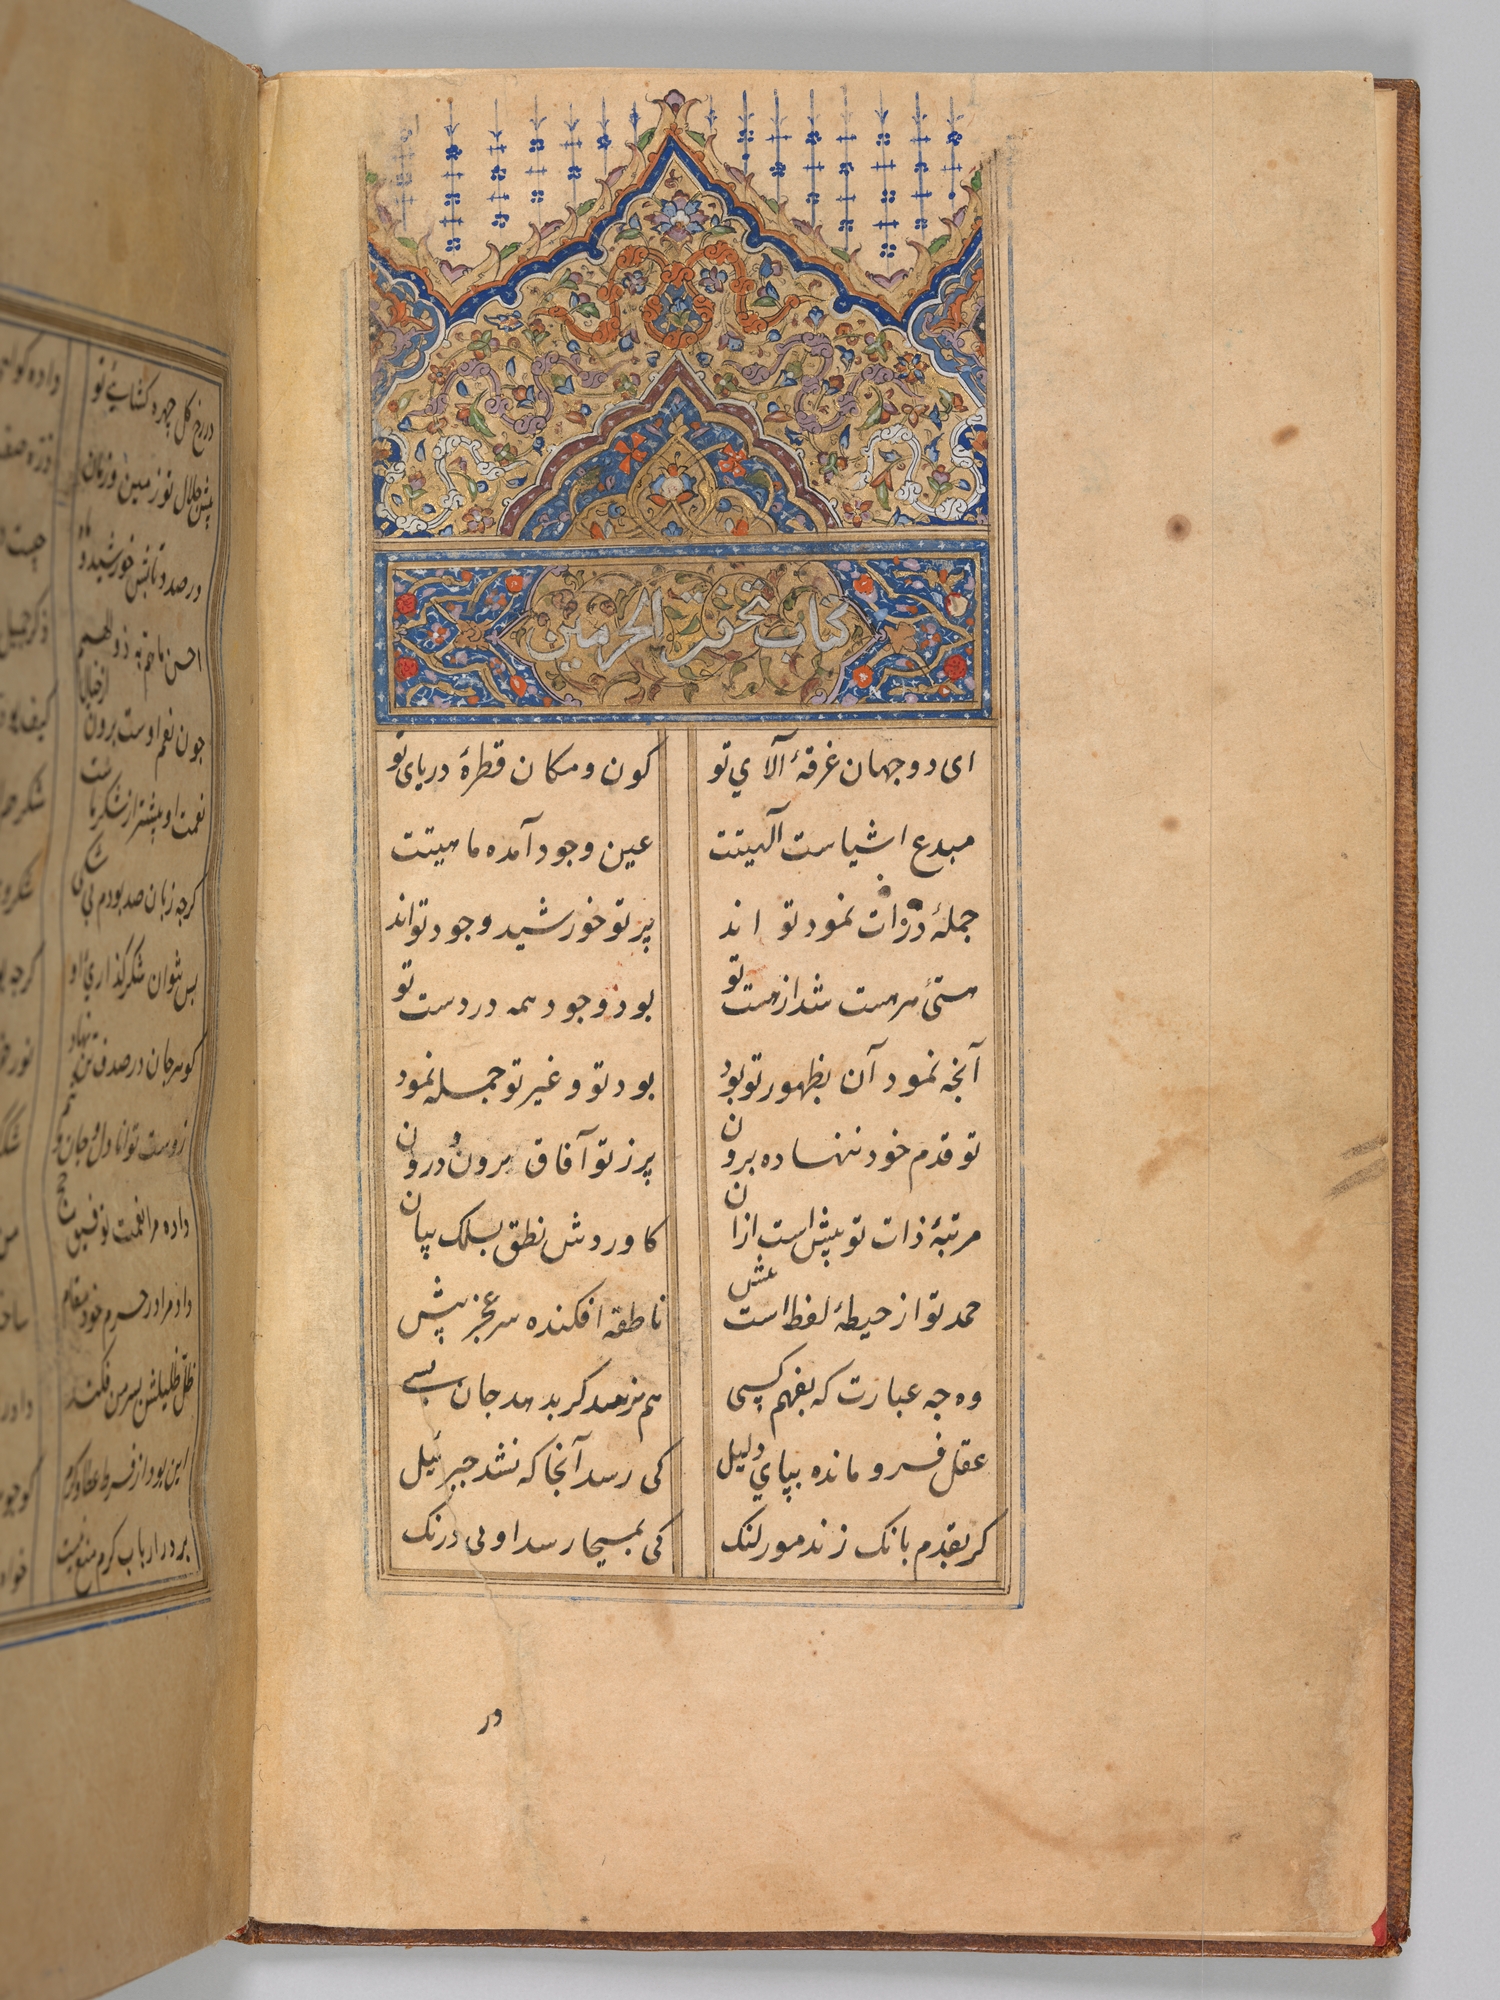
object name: illustrated manuscript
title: Futuh al-Haramain (Description of the Holy Cities)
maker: muhi al-din lari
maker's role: author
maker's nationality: iranian or indian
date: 1534-1566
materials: gold, ink, leather, paper, watercolor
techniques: bookbinding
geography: turkey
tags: cities,mosques